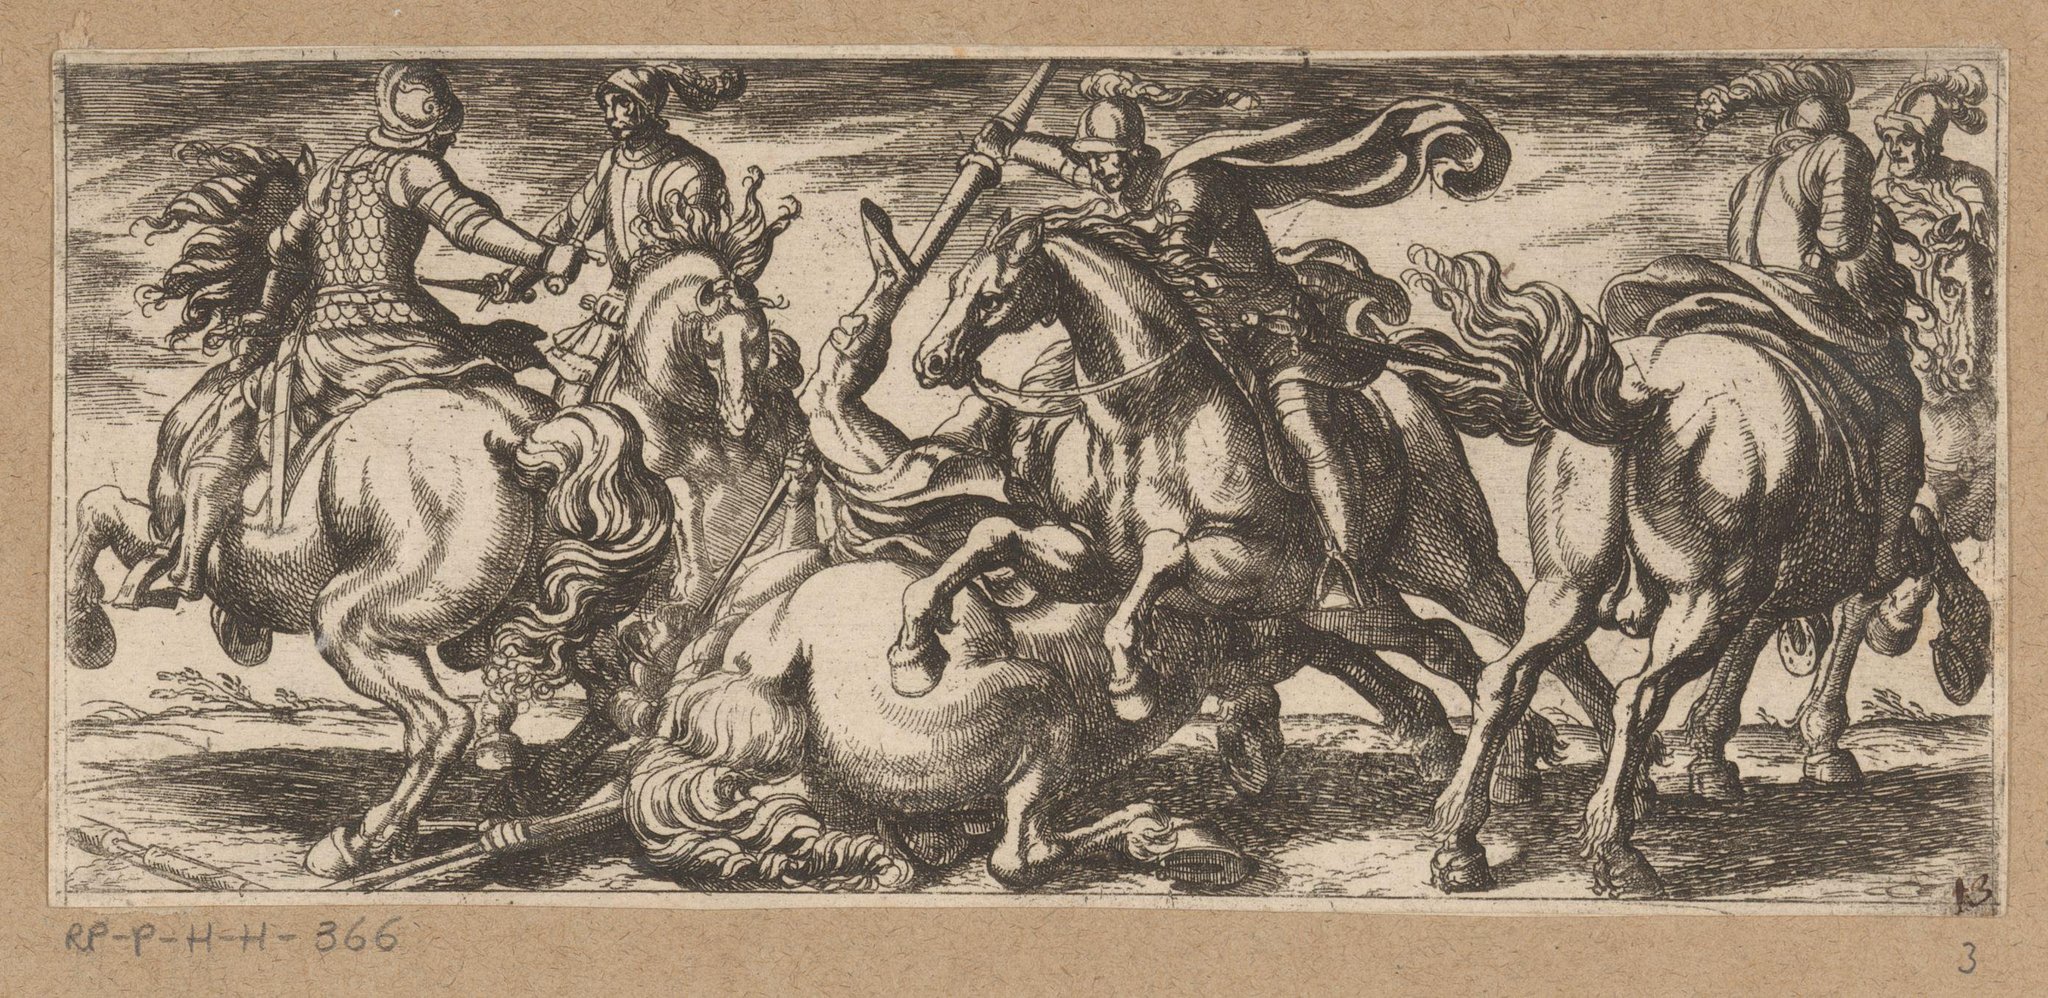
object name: print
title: Gevechtsscènes (serie 1)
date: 1565-1630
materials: paper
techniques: etching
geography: italy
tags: battle, warfare; military affairs (+ cavalry, horsemen), the soldier; the soldier's life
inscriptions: collector's mark: Lugt 11, number: ‘13’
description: Deze prent maakt deel uit van een reeks van 10 prenten (+ titelprent) met gevechtsscènes. Antonio Tempesta maakte ook een tweede serie met gevechtsscènes van 9 prenten (+titelprent).